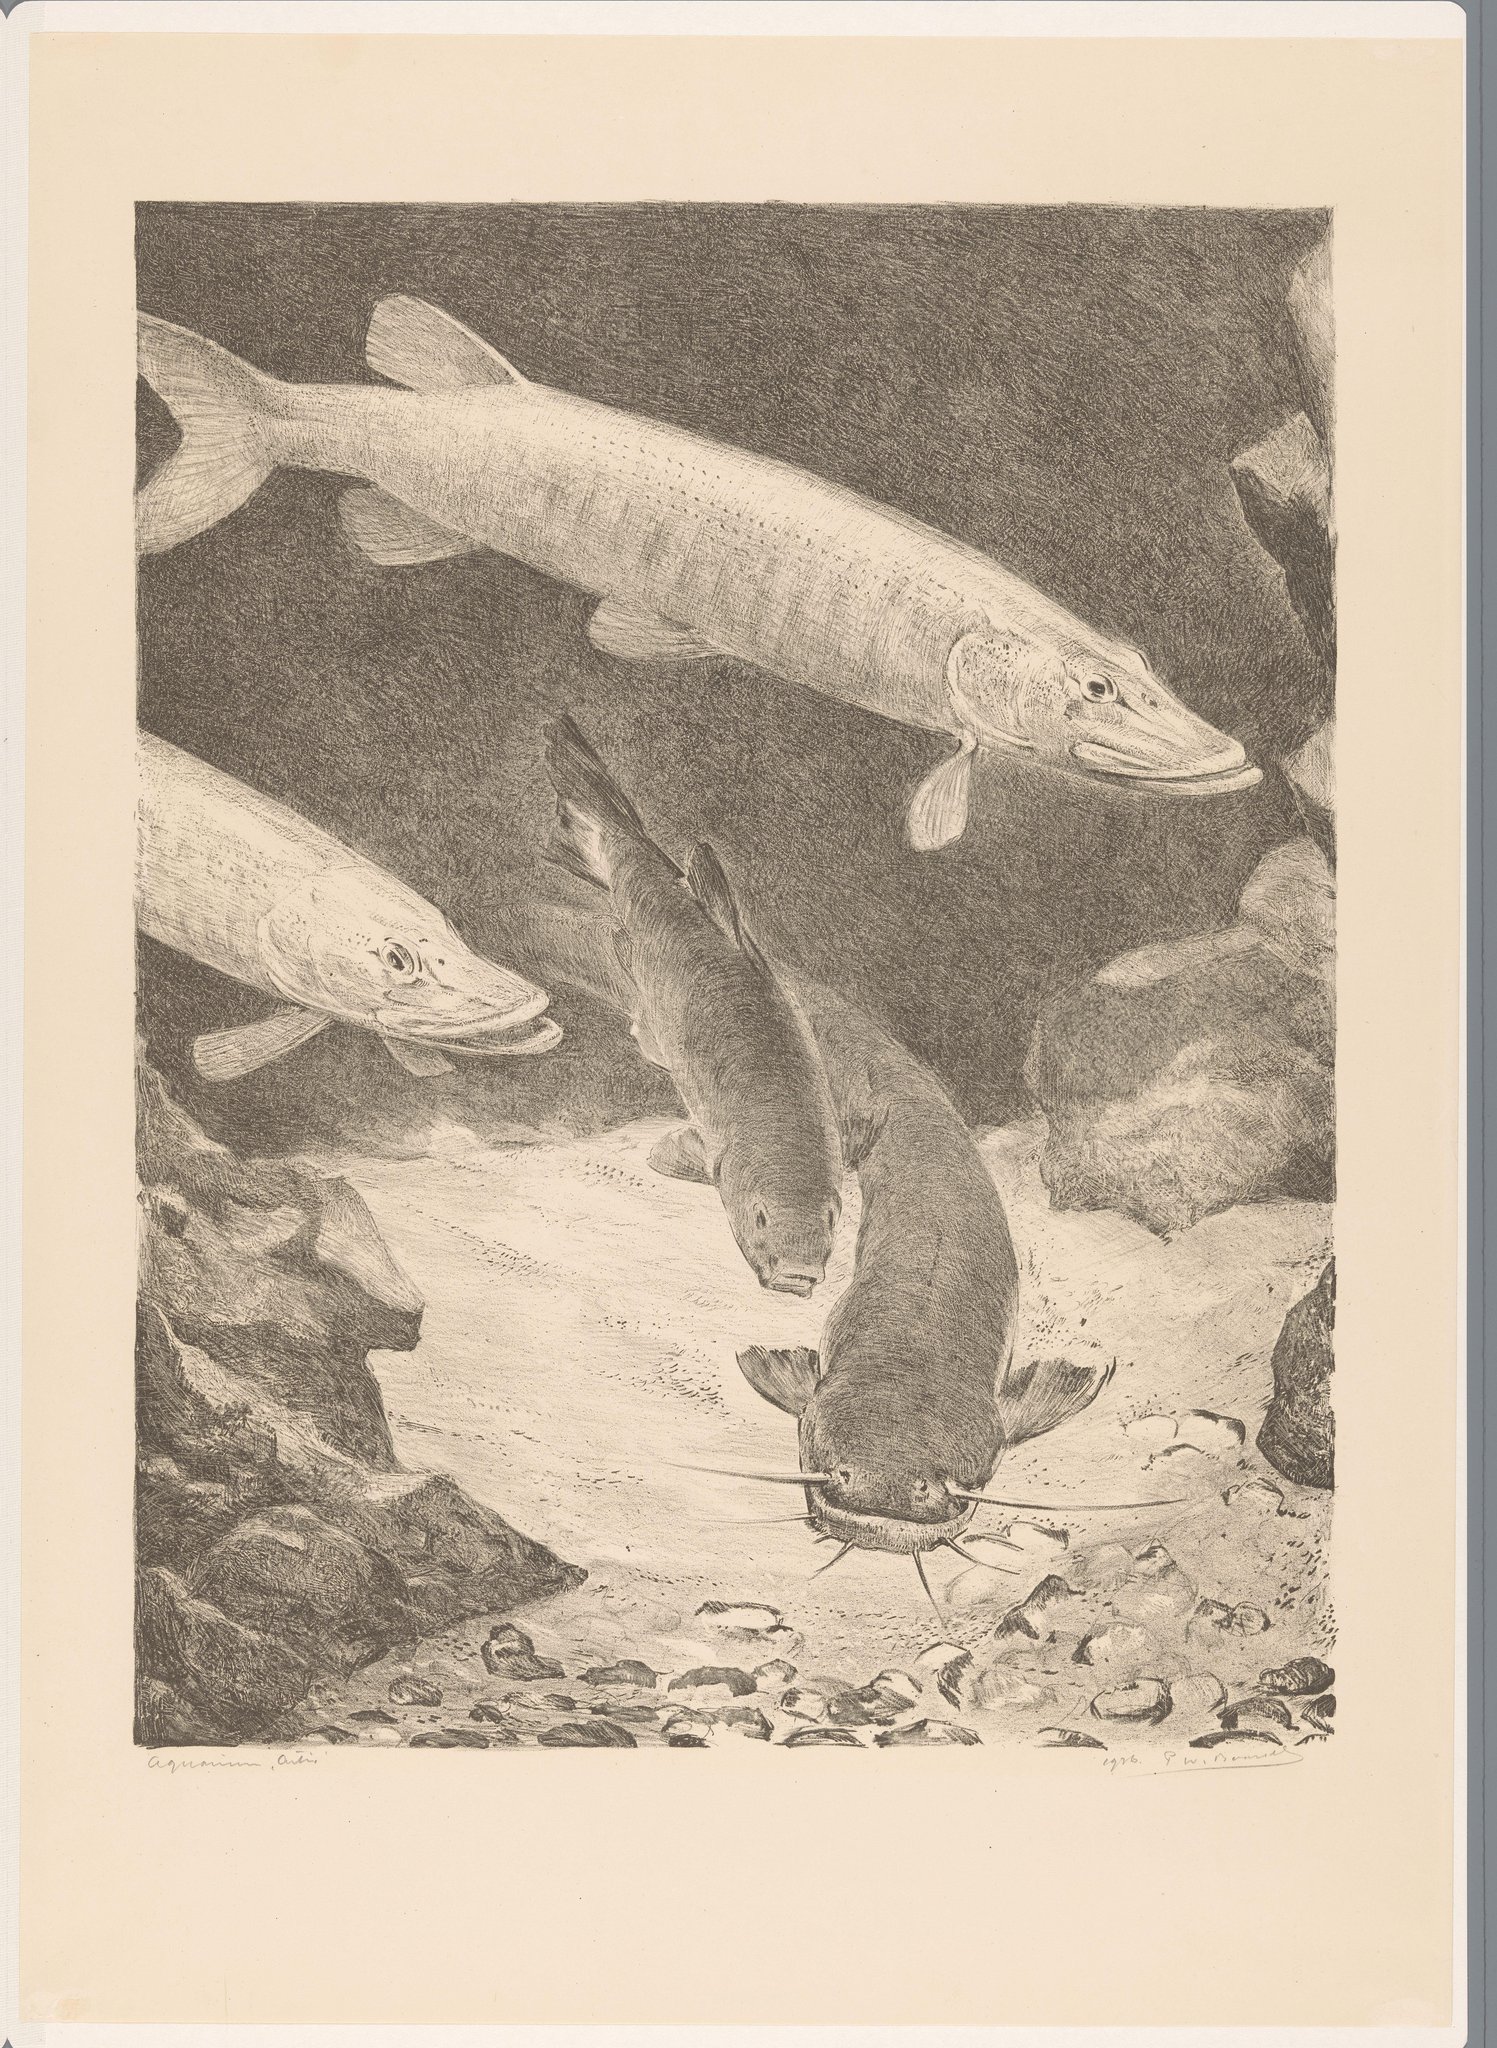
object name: print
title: Aquarium, Artis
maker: pieter willem van baarsel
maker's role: draughtsman, painter, print maker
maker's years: 1879-1949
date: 1936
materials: paper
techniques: lithograph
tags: aquarium, bony fishes: sheat-fish, bony fishes: pike, bony fishes: catfish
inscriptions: collector's mark: Lugt 2228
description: Een meerval, twee snoeken en een andere vis zwemmend tussen rotsen.